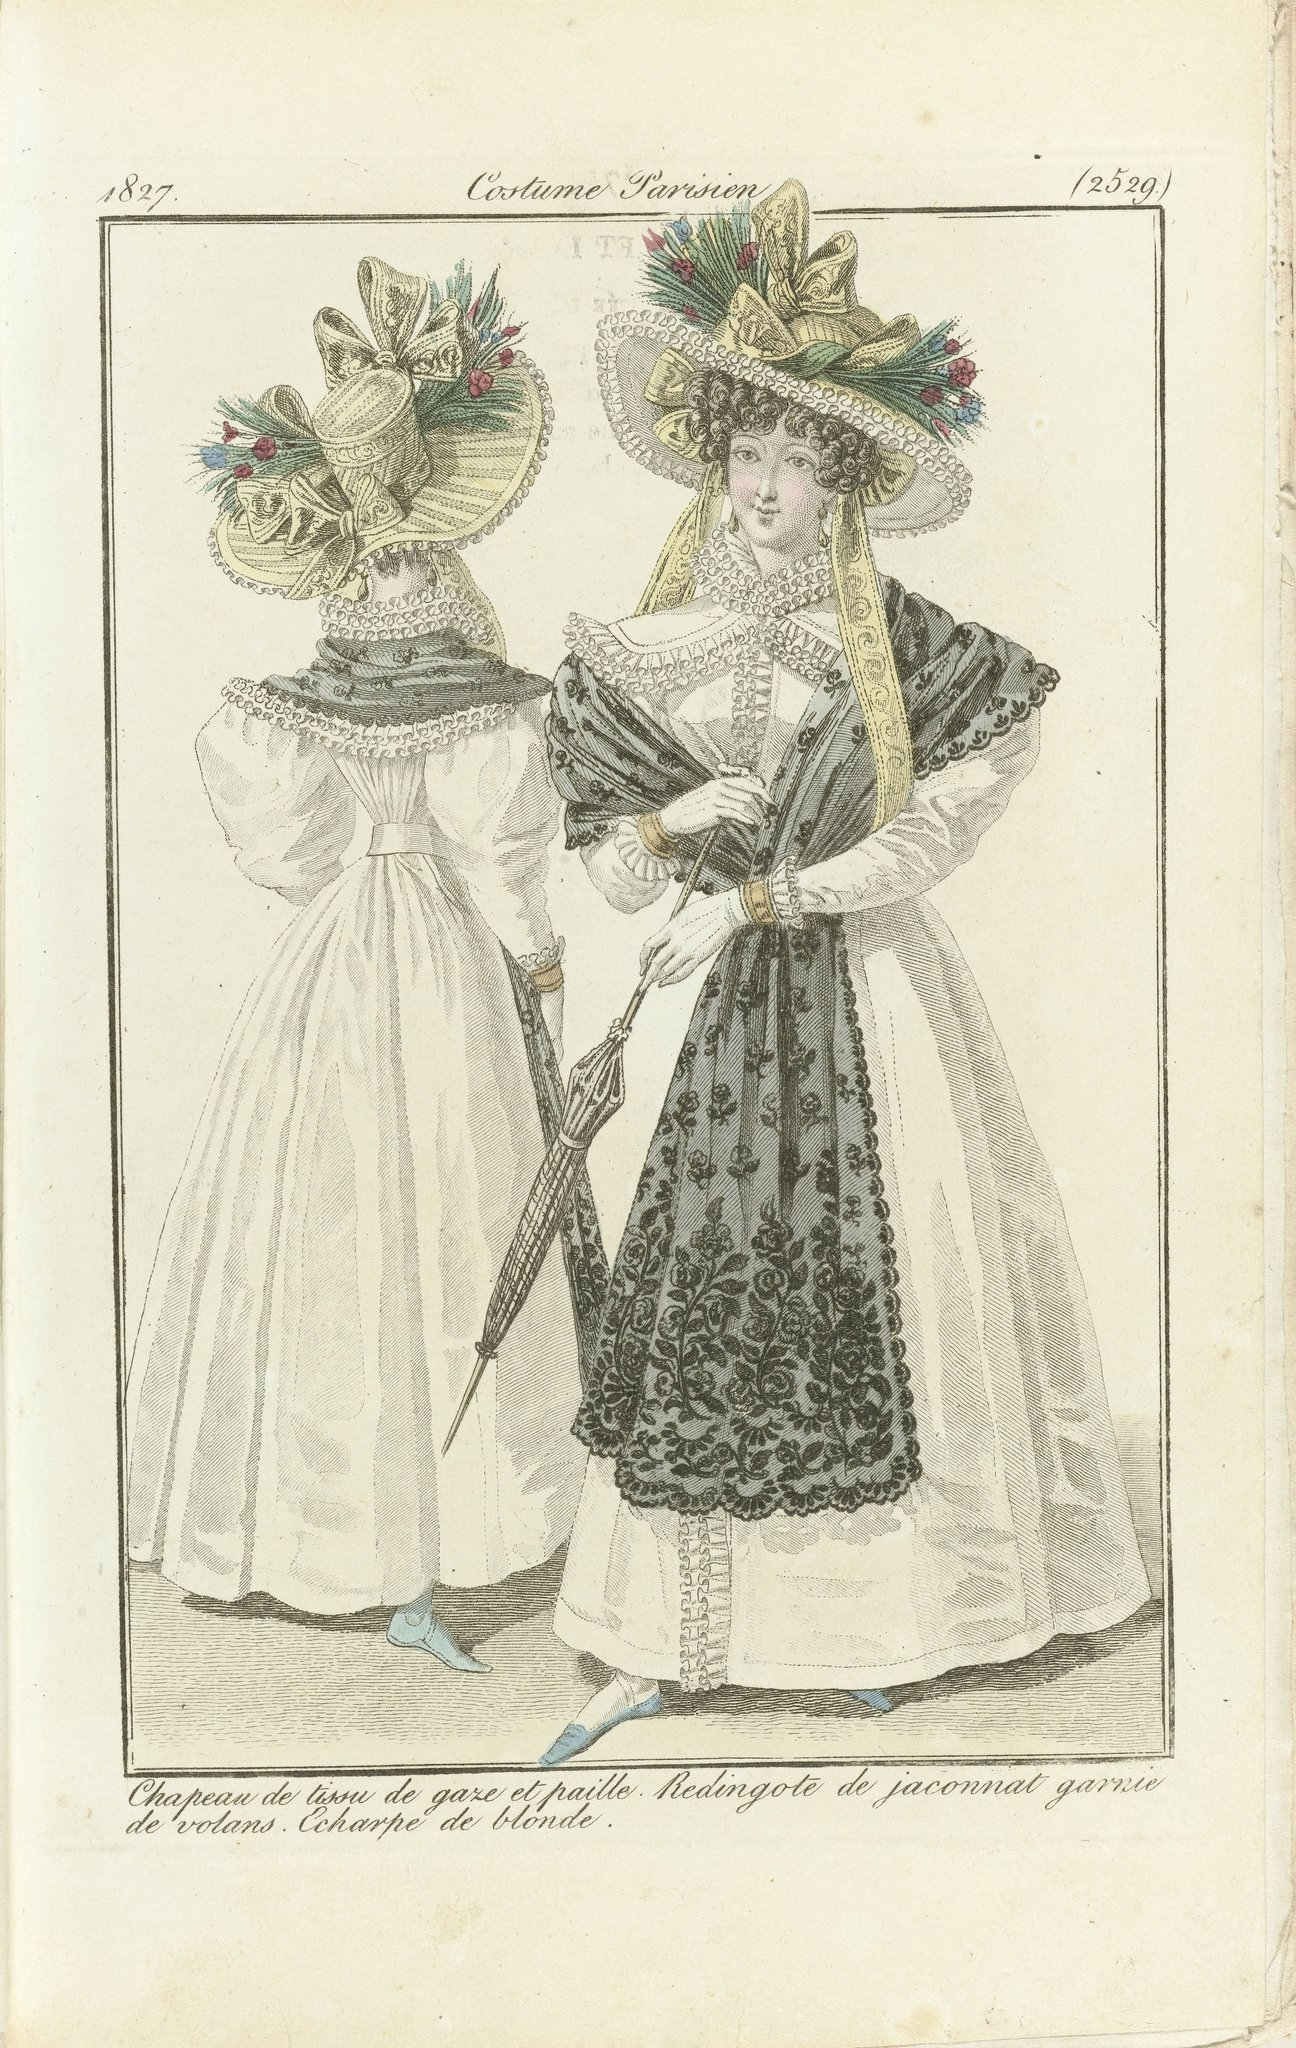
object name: fashion print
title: Journal des dames et des modes 1827, Costume Parisien (2529)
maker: Anonymous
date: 1827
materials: paper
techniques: etching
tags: fashion plates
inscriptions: date